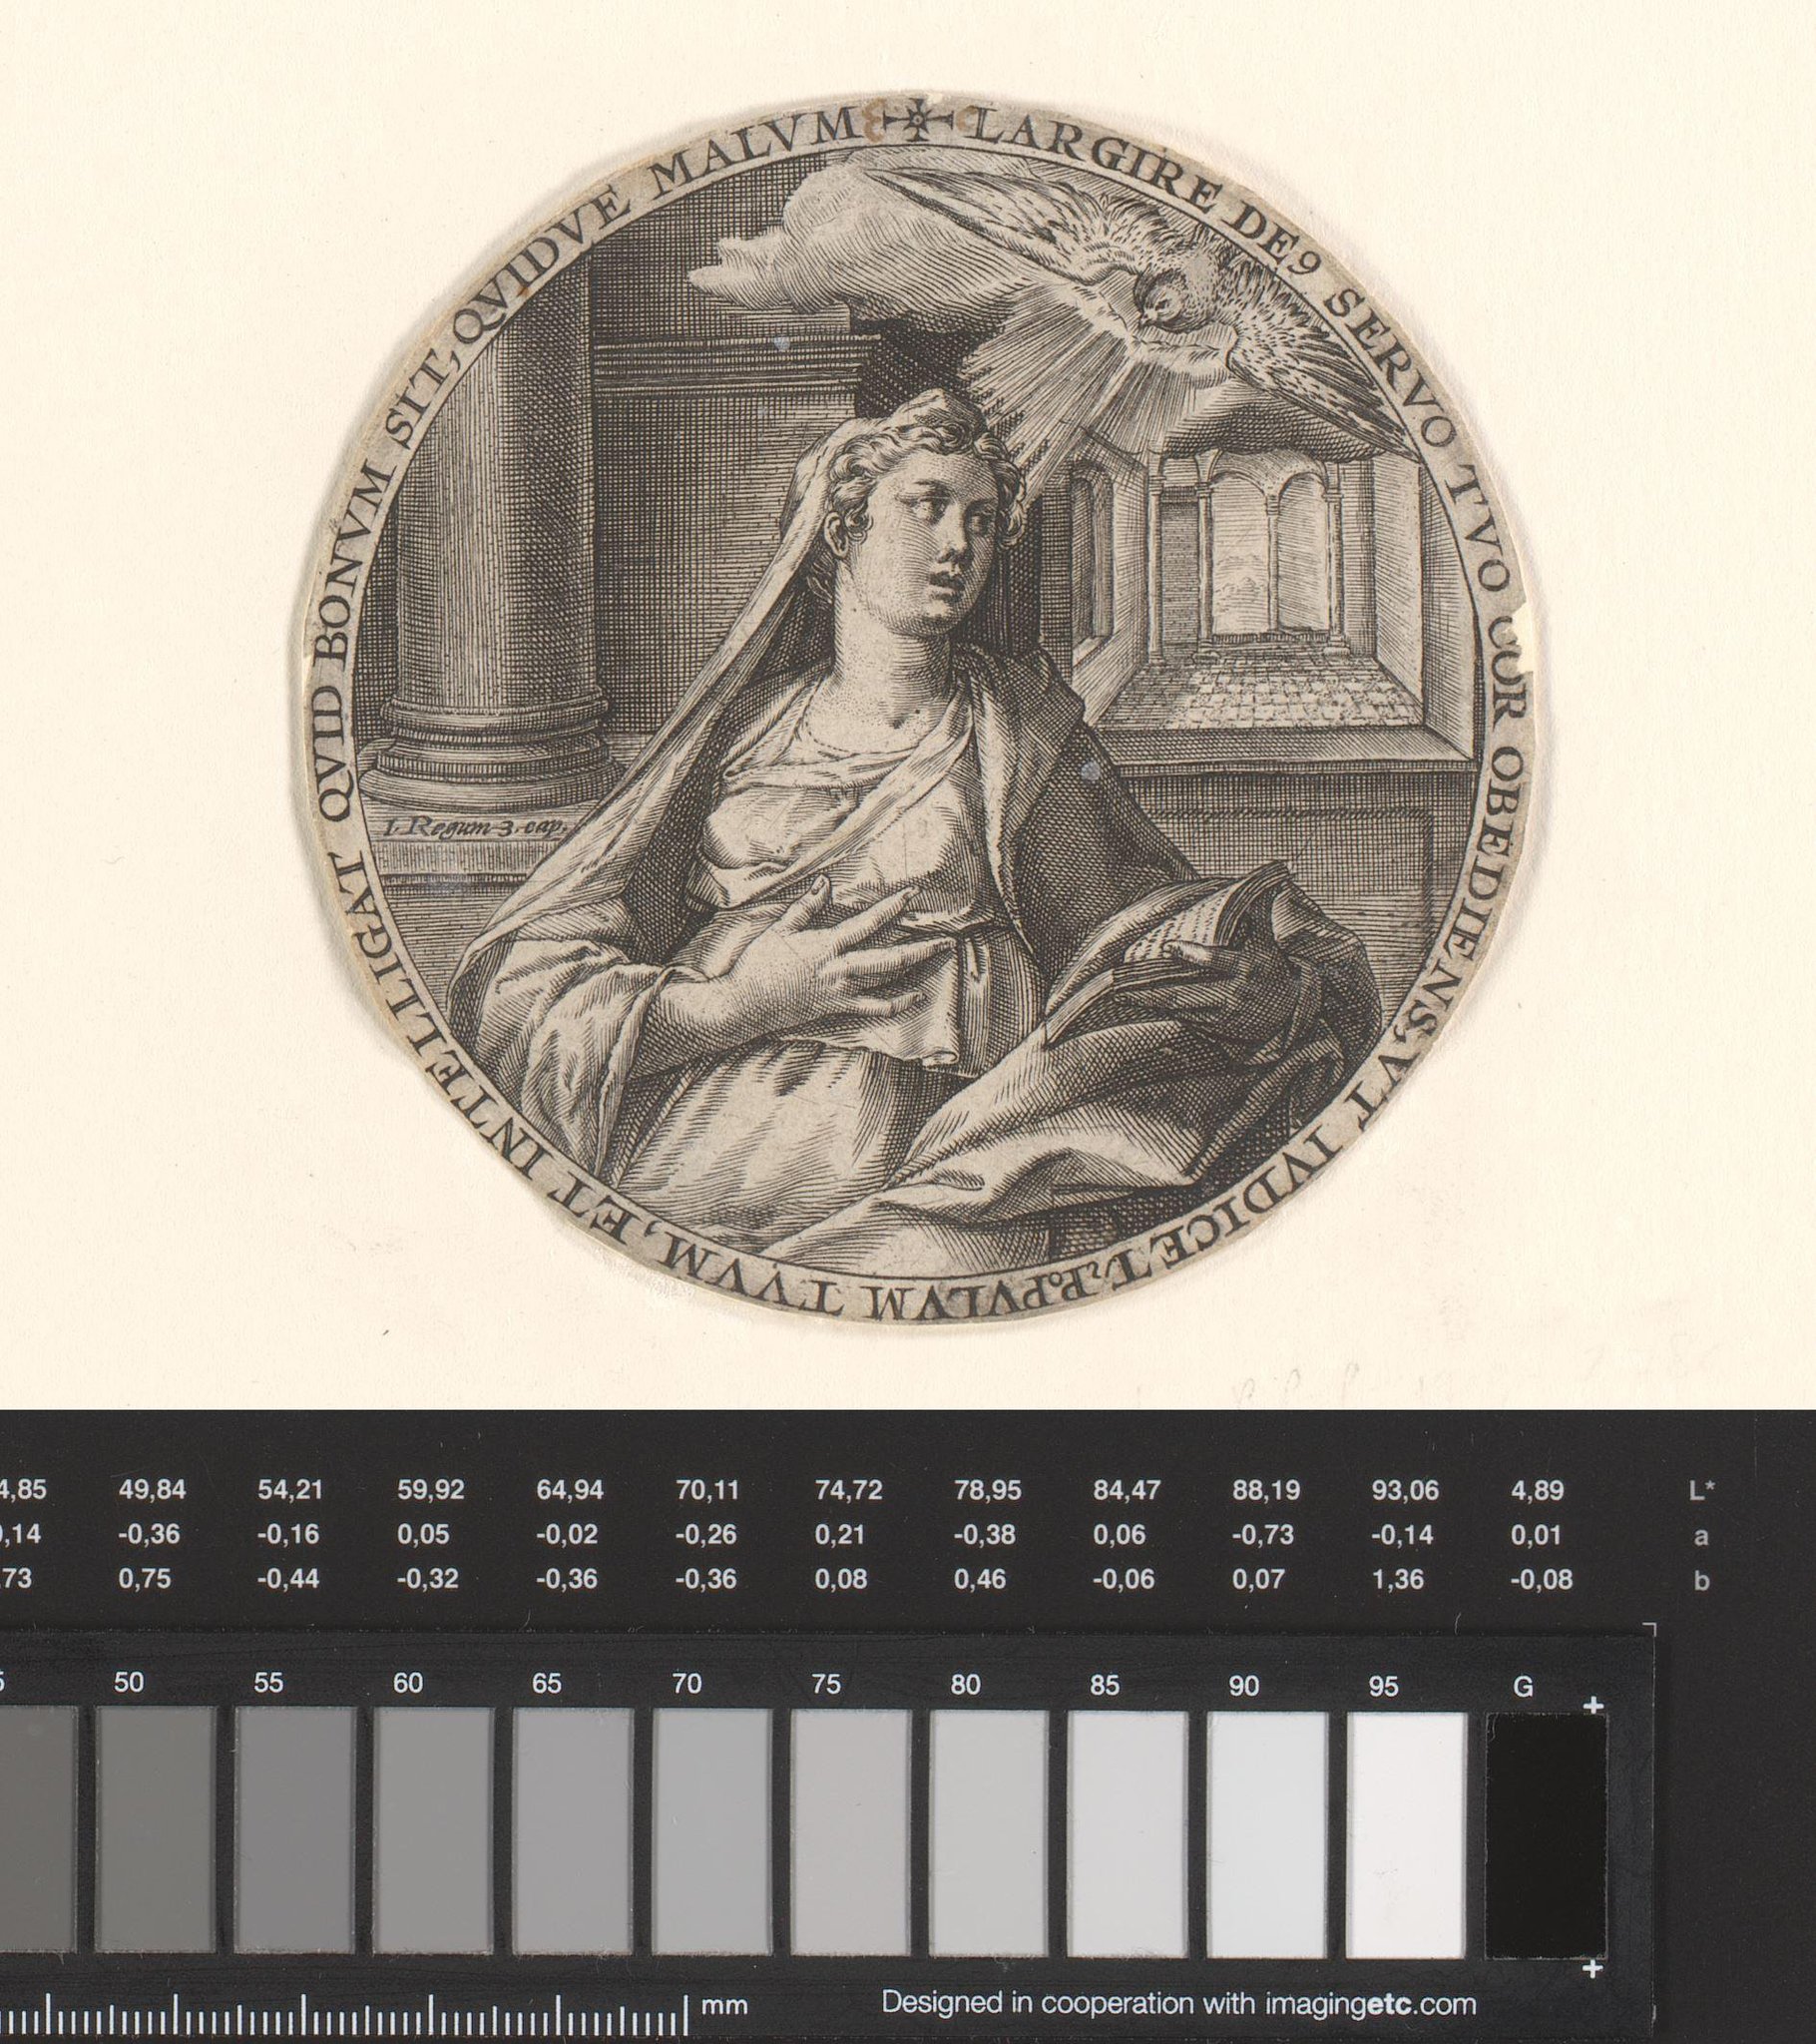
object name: print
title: Theologische deugden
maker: crispijn van de passe (i)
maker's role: draughtsman, print maker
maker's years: 1564-1637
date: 1600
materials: paper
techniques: engraving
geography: cologne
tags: 'obedienza verso dio' (ripa), holy ghost represented as a dove (in flames)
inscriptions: monogram: ‘EC’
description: Kerkinterieur met de vrouwelijke personificatie van Gehoorzaamheid (Obedientia), met een opengeslagen boek in haar hand. Ze kijkt op naar de hemel waar de duif van de Heilige Geest verschijnt. Op het basement van de zuil staat een verwijzing naar het Bijbelboek 1 Kon. 3, in het Latijn.